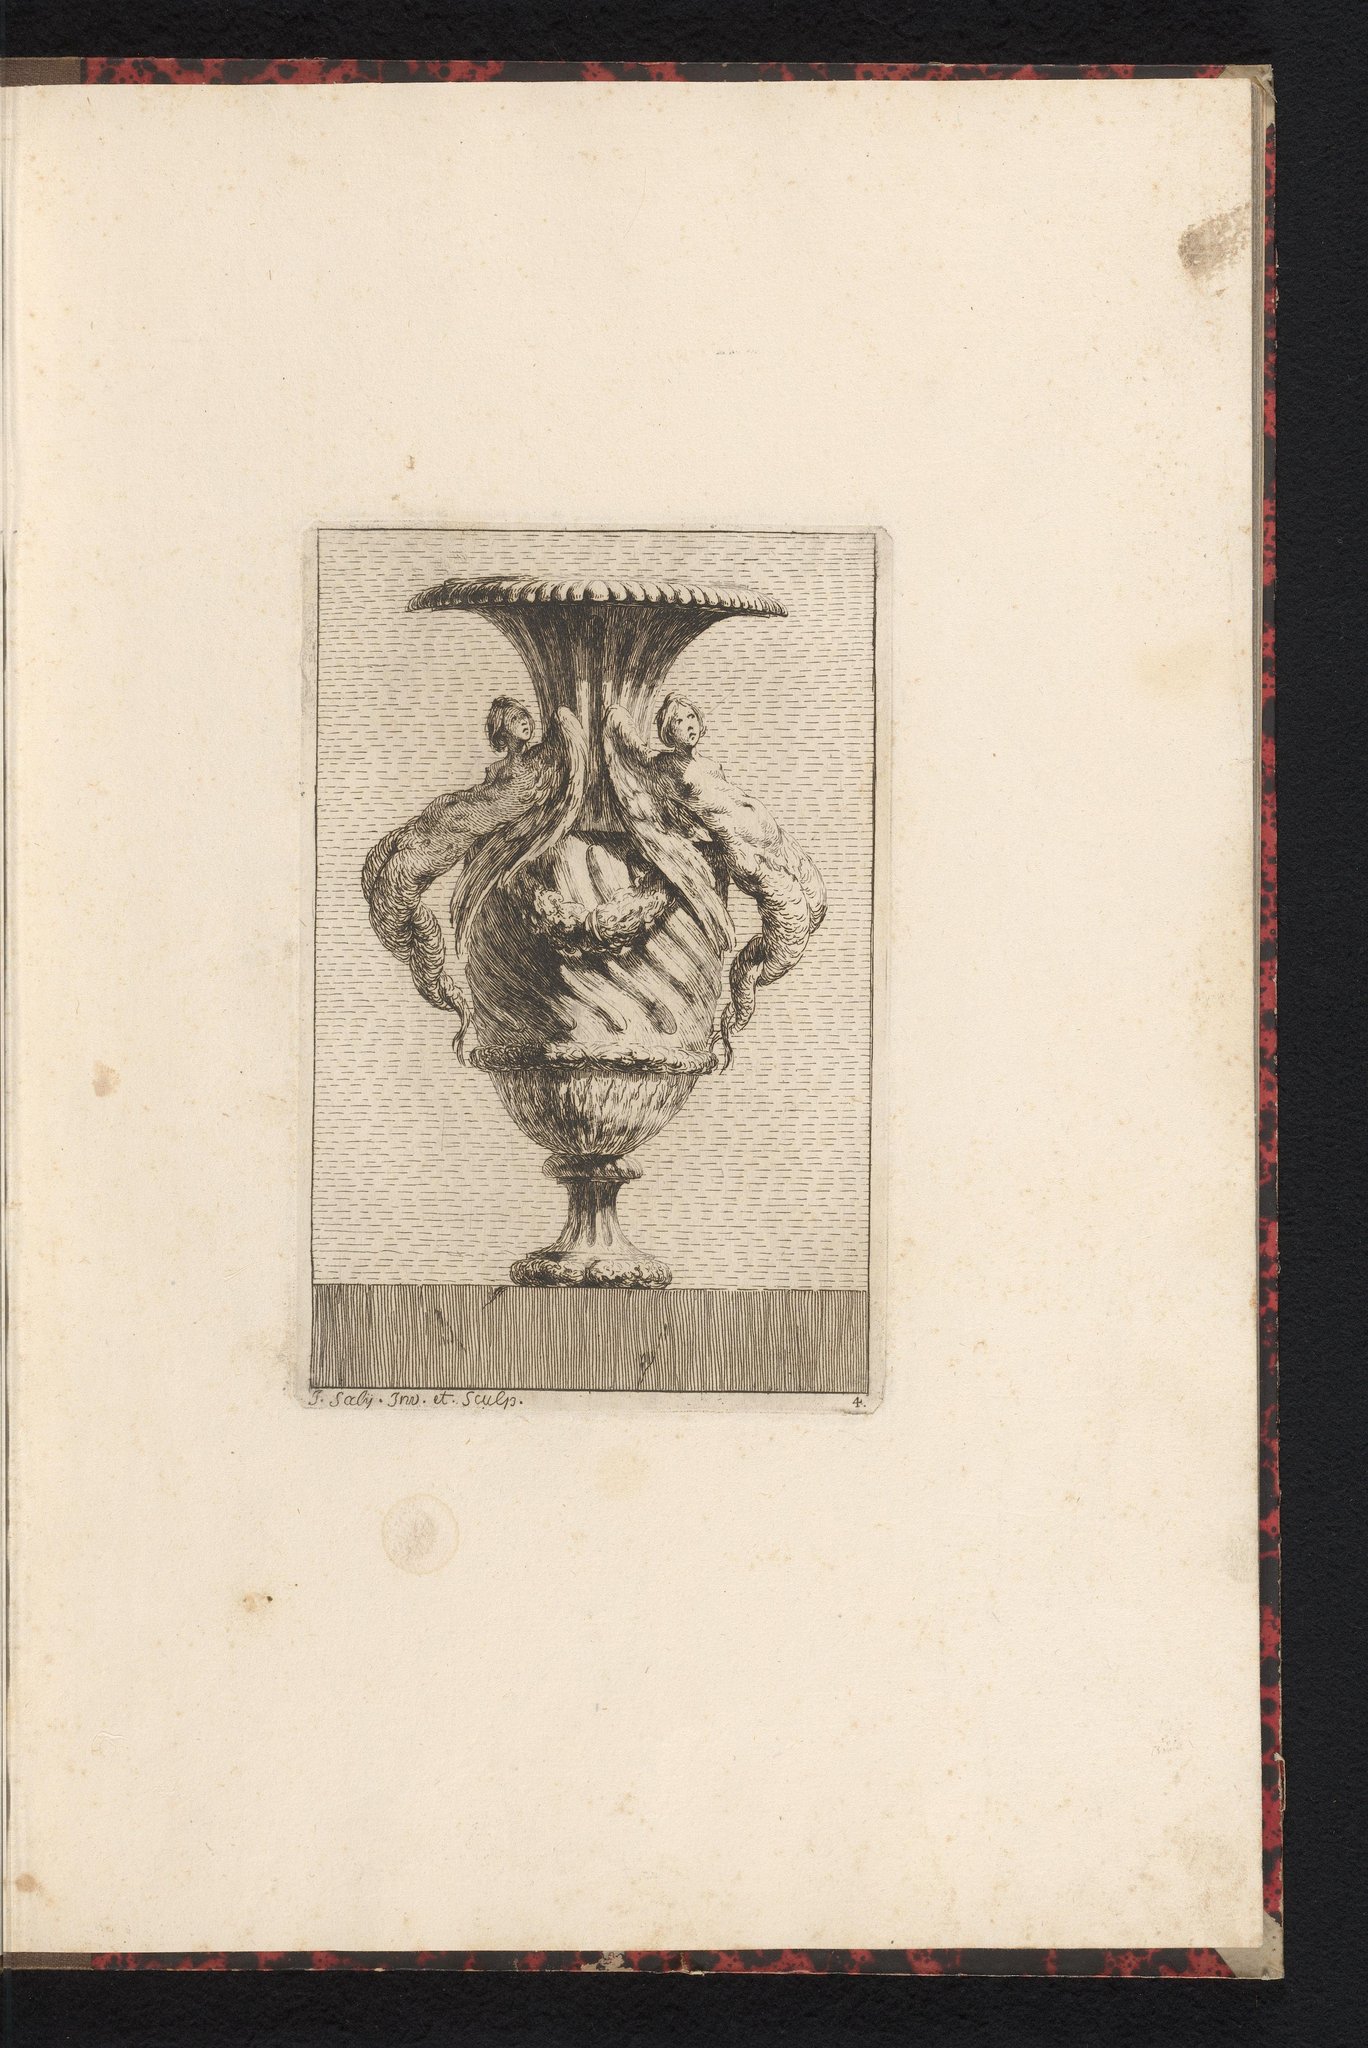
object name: ornament print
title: Vaas met twee meerminnen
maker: jacques francois joseph saly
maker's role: print maker, sculptor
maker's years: 1717-1776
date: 1746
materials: paper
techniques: etching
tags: merman - aa - mermaid, siren, vase ~ ornament, tales and fairy tales (with title)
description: De twee figuren zijn gevleugeld. Ook de gespleten staart van de beide figuren suggereert dat het hier mogelijk om Melusine gaat. Deze prent maakt deel uit van een album.